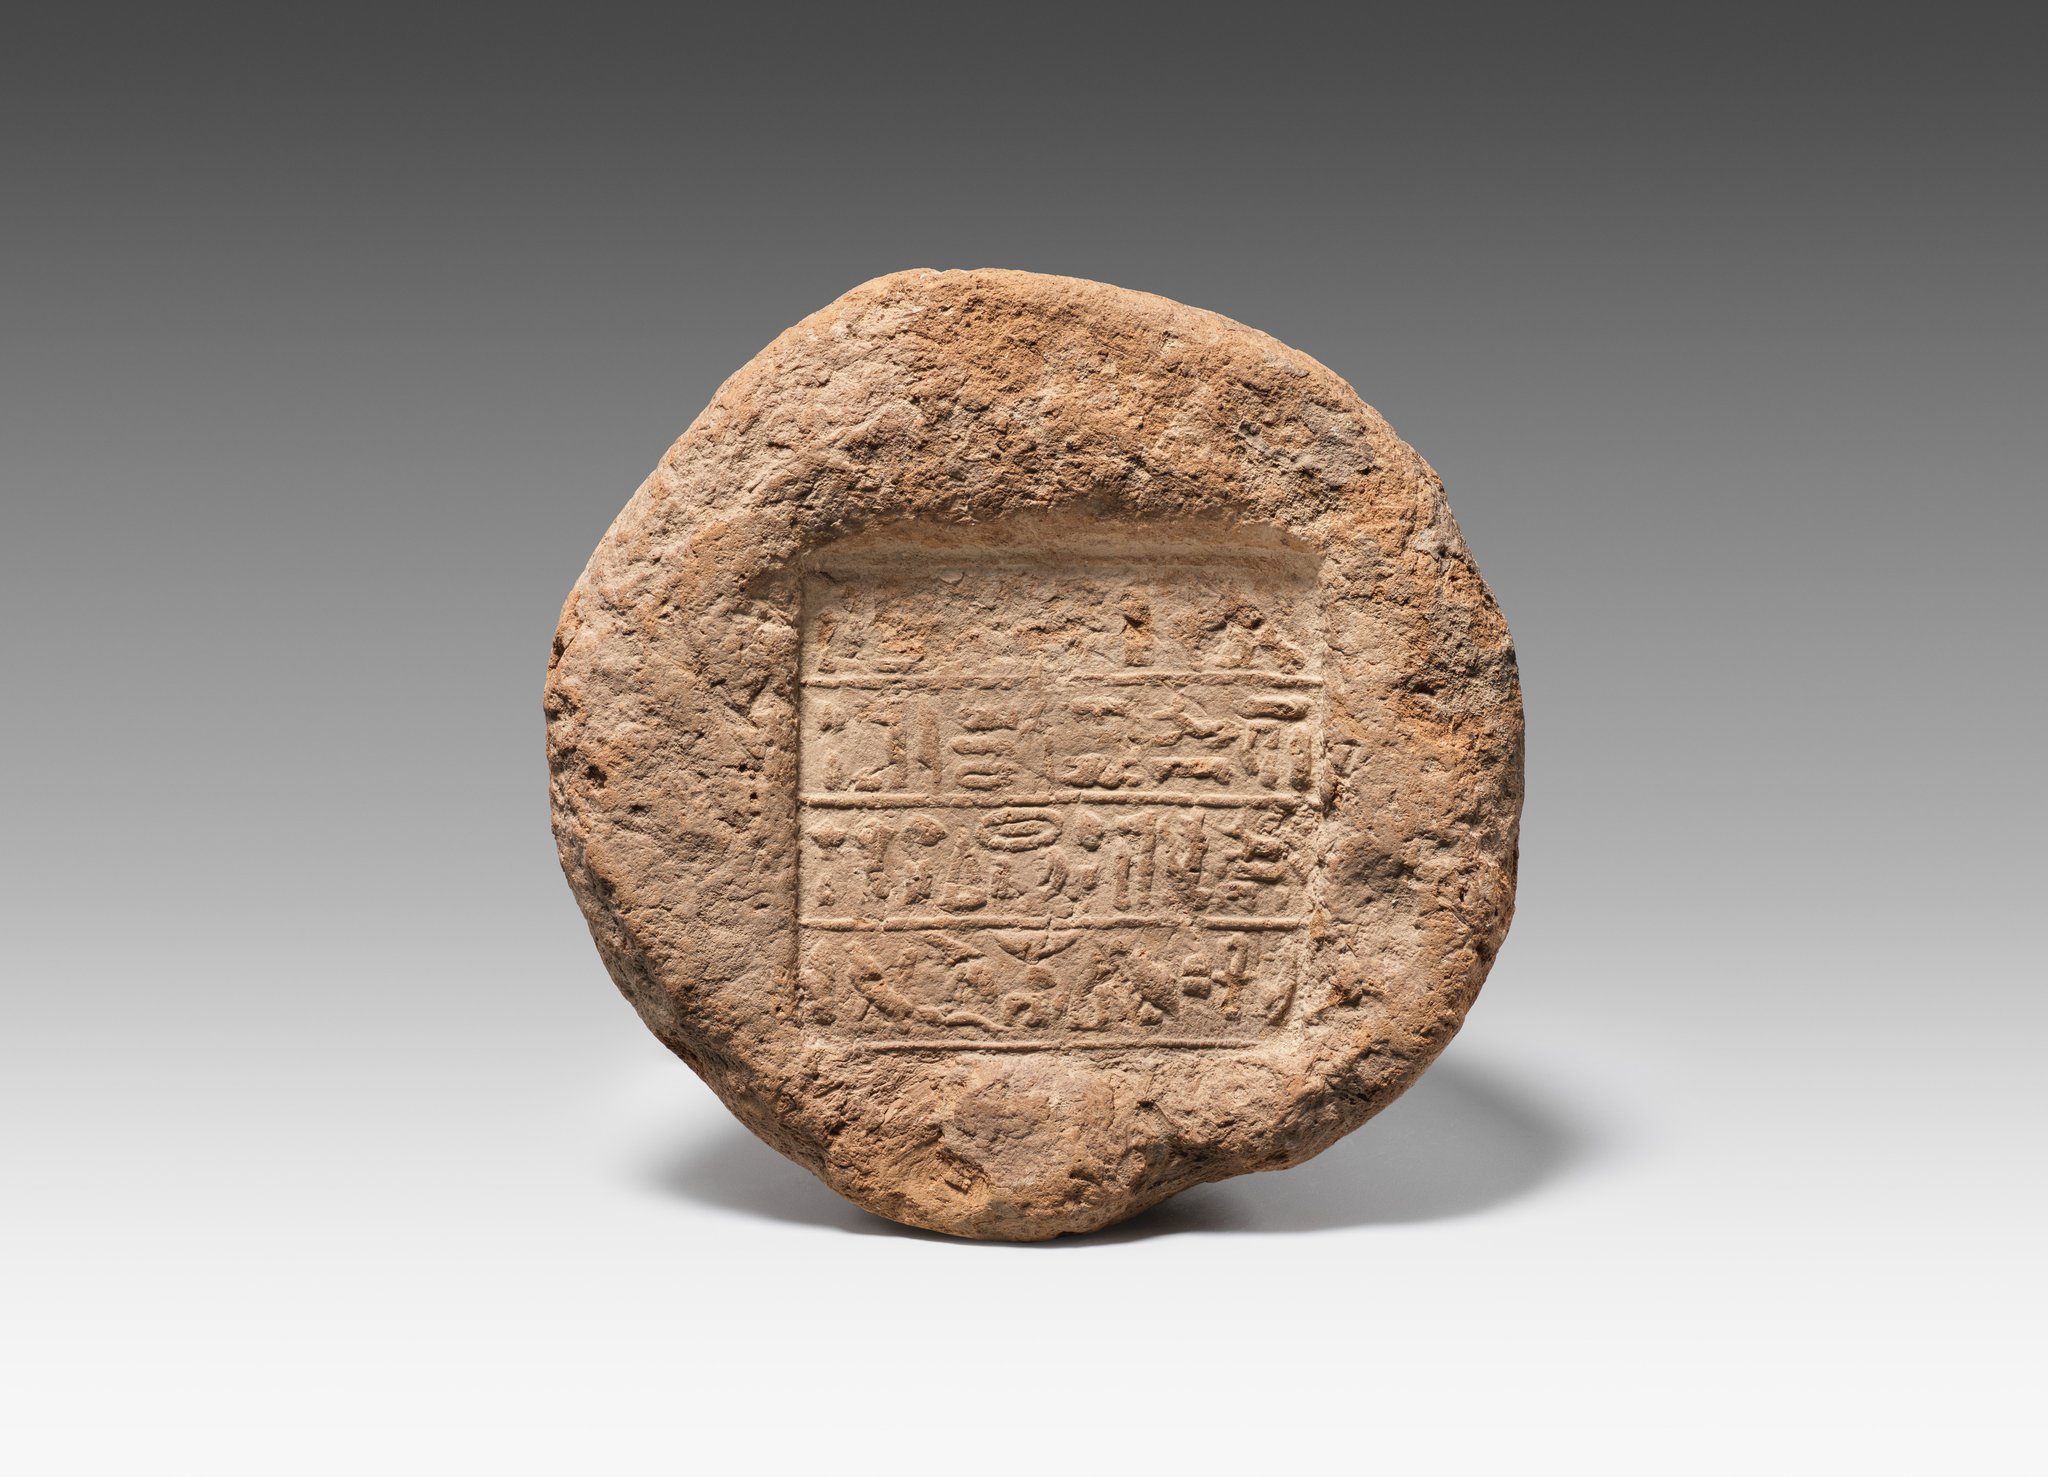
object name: funerary cone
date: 1550-1295 BCE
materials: pottery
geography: egypt